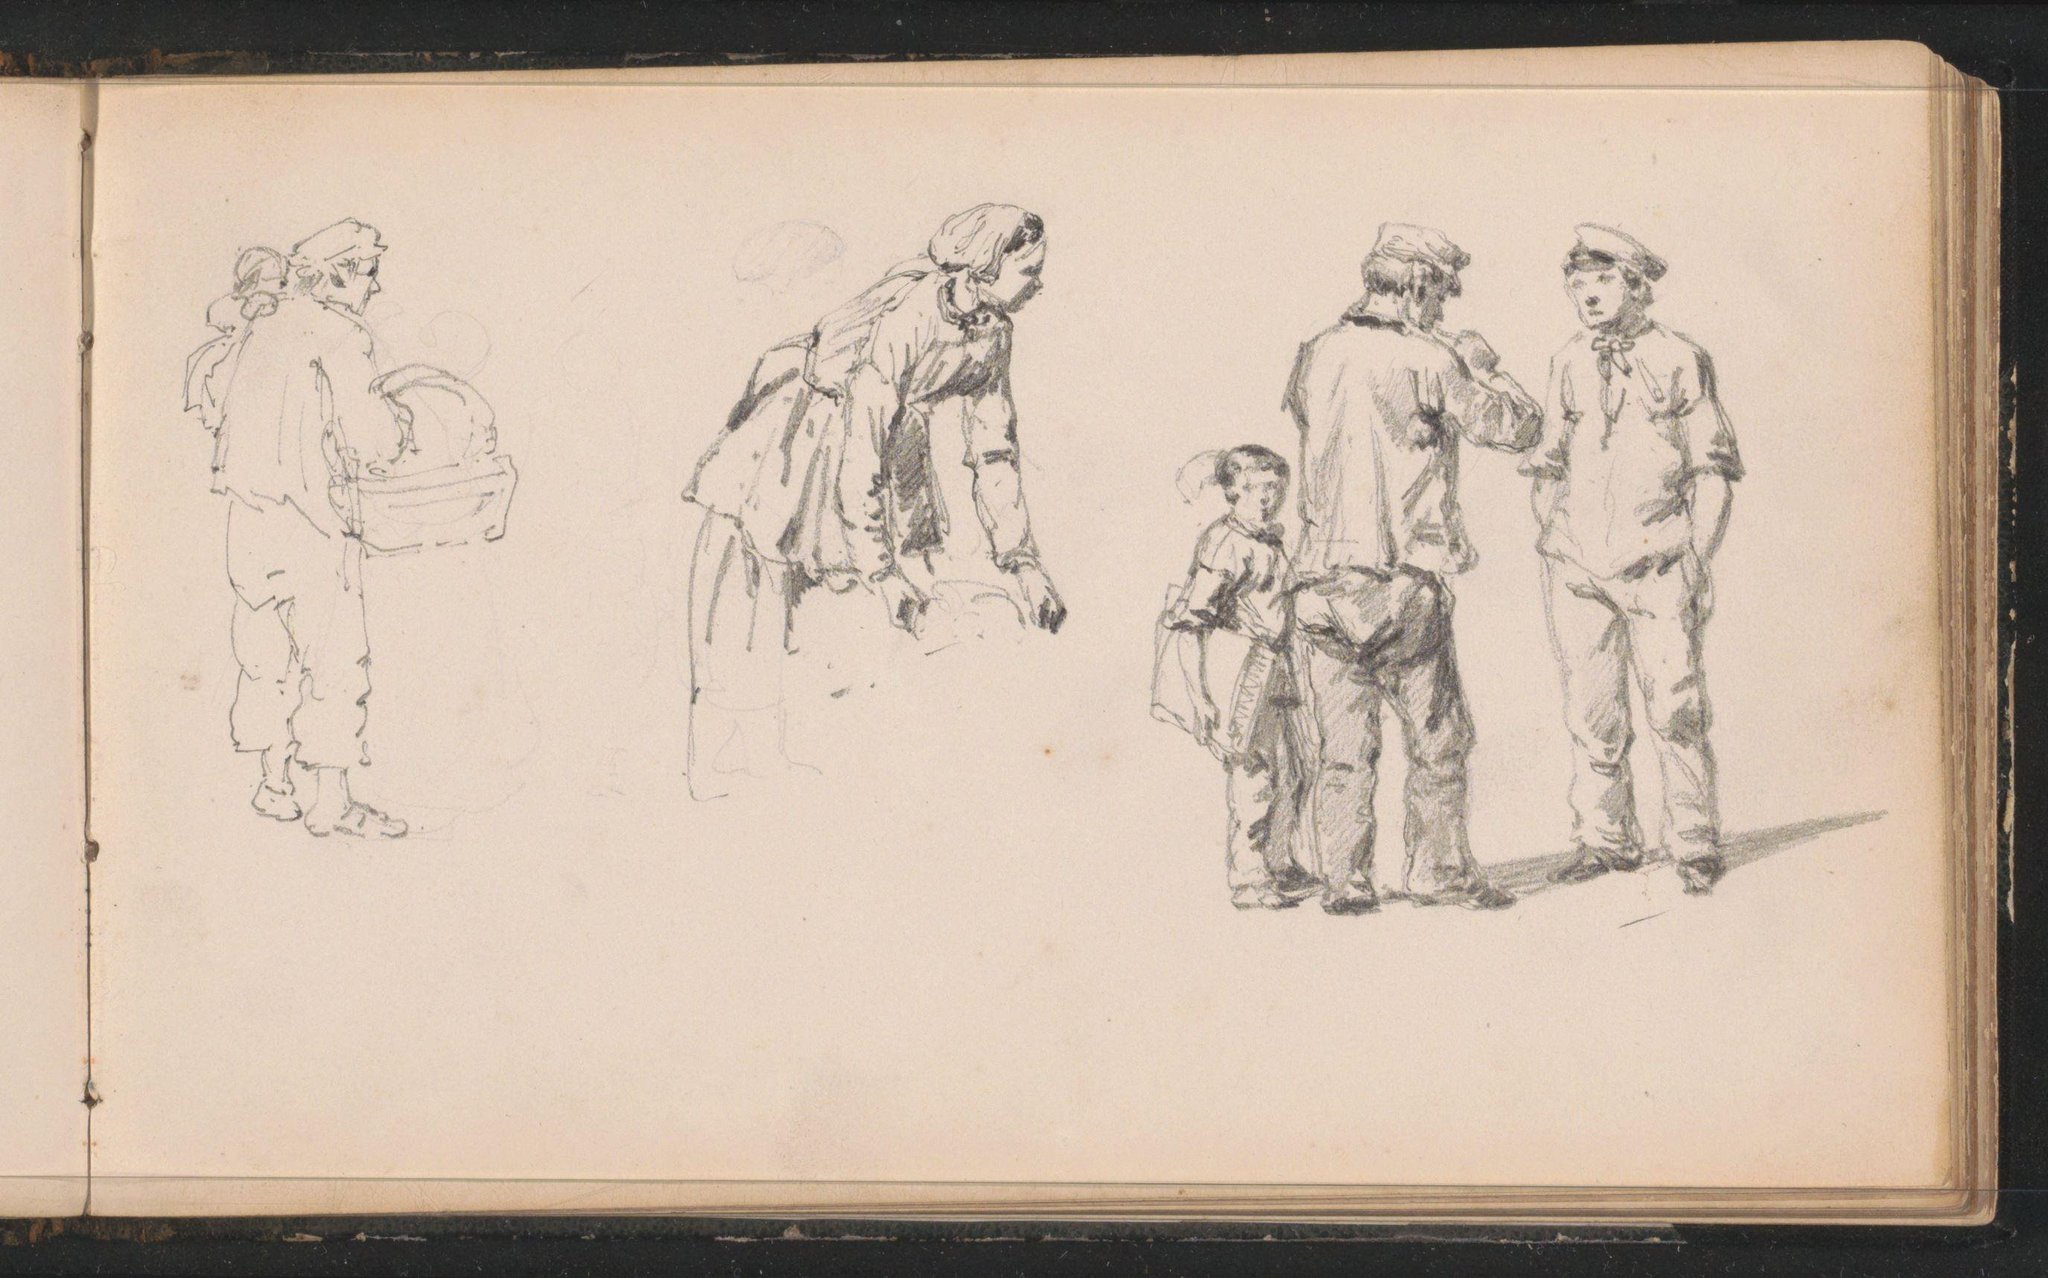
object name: sketchbook leaf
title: Figuurstudies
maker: cornelis springer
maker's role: draughtsman, painter, print maker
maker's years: 1817-1891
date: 1856-1861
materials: paper, pencil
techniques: stumping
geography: zeeland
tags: adult woman, adult man, child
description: Figuurstudies. Blad 17 uit een schetsboek met 44 bladen vervaardigd in Zeeland en Utrecht.